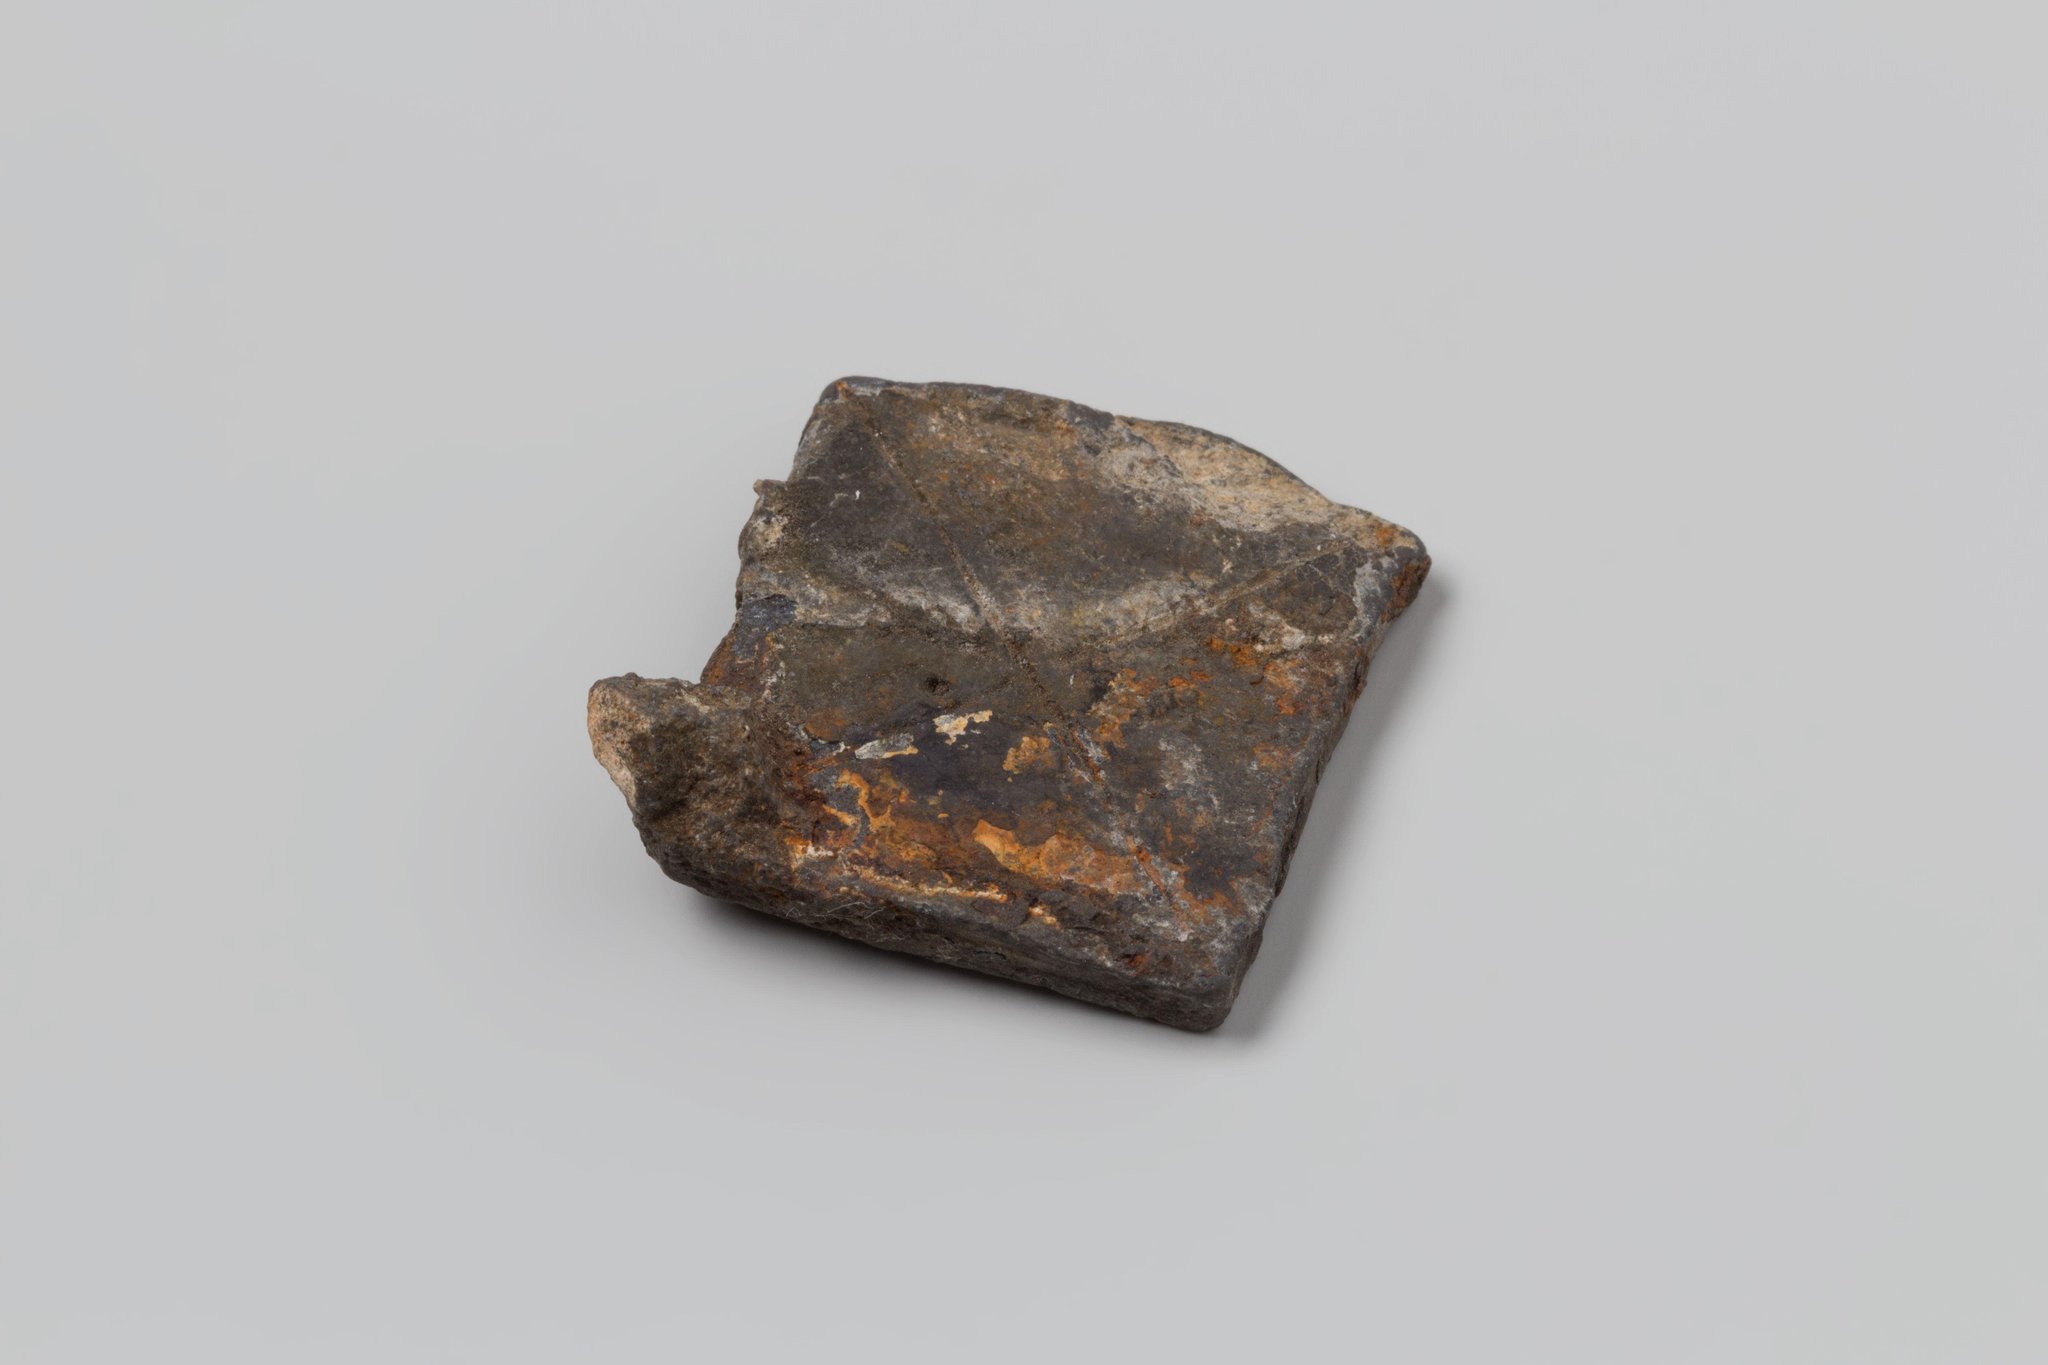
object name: gaming counter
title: Speelpenning uit het wrak van de Oost-Indiëvaarder Hollandia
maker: Anonymous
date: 1700-1743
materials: lead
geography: netherlands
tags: verenigde oostindische compagnie, hollandia (schip), annet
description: Rectangular, square, flat, engraved diagonal cross on one side, game token.